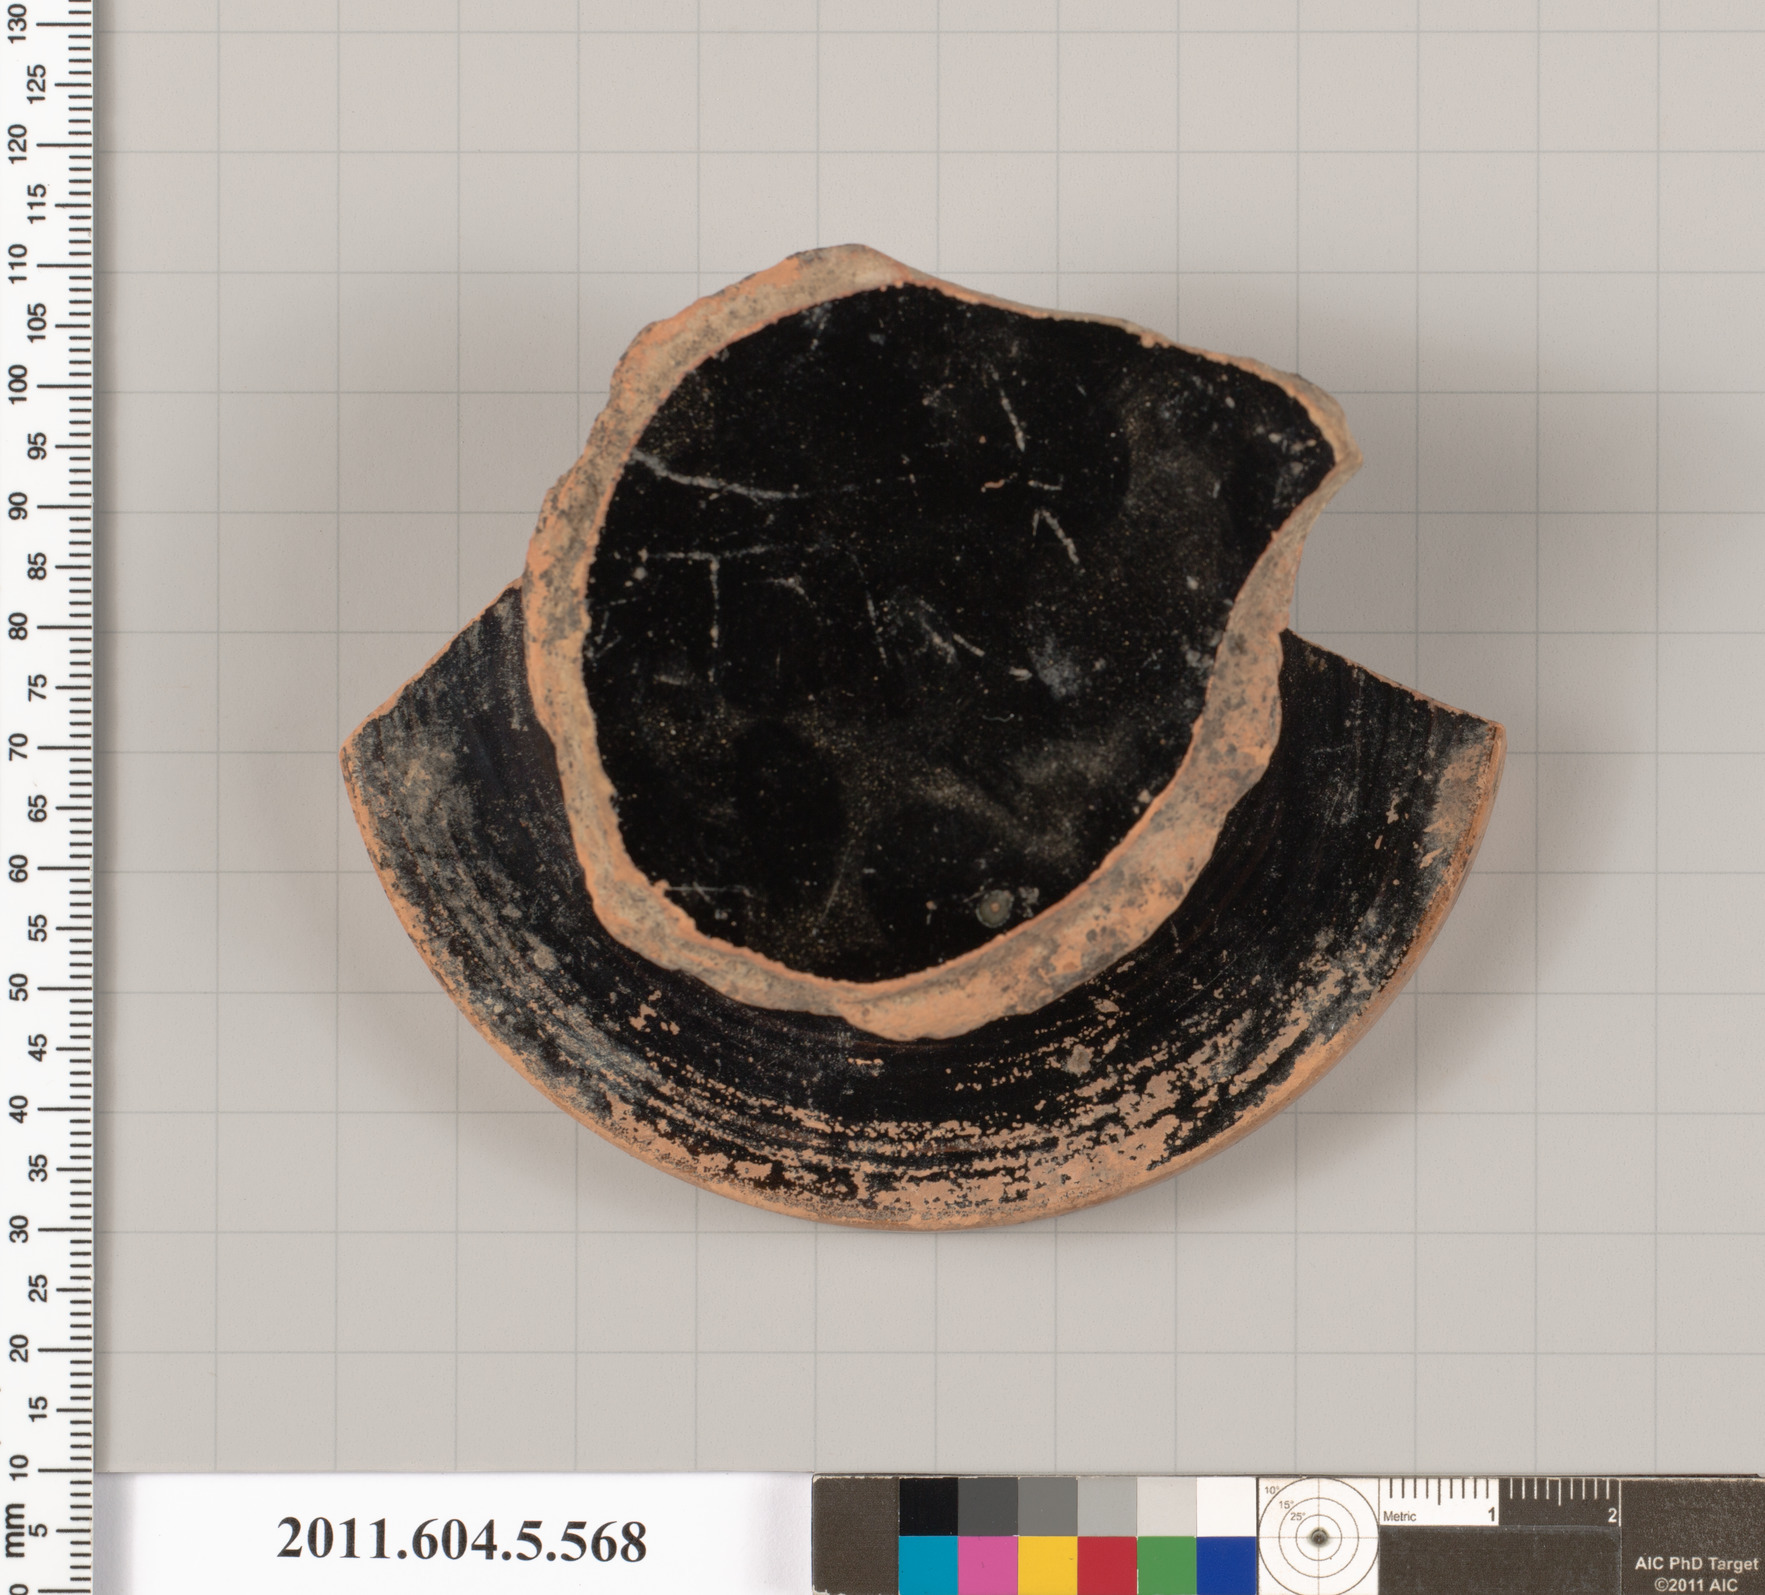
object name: stemless kylix fragment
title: Terracotta fragment of a stemless kylix (drinking cup)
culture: greek, attic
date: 600-401 BCE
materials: terracotta